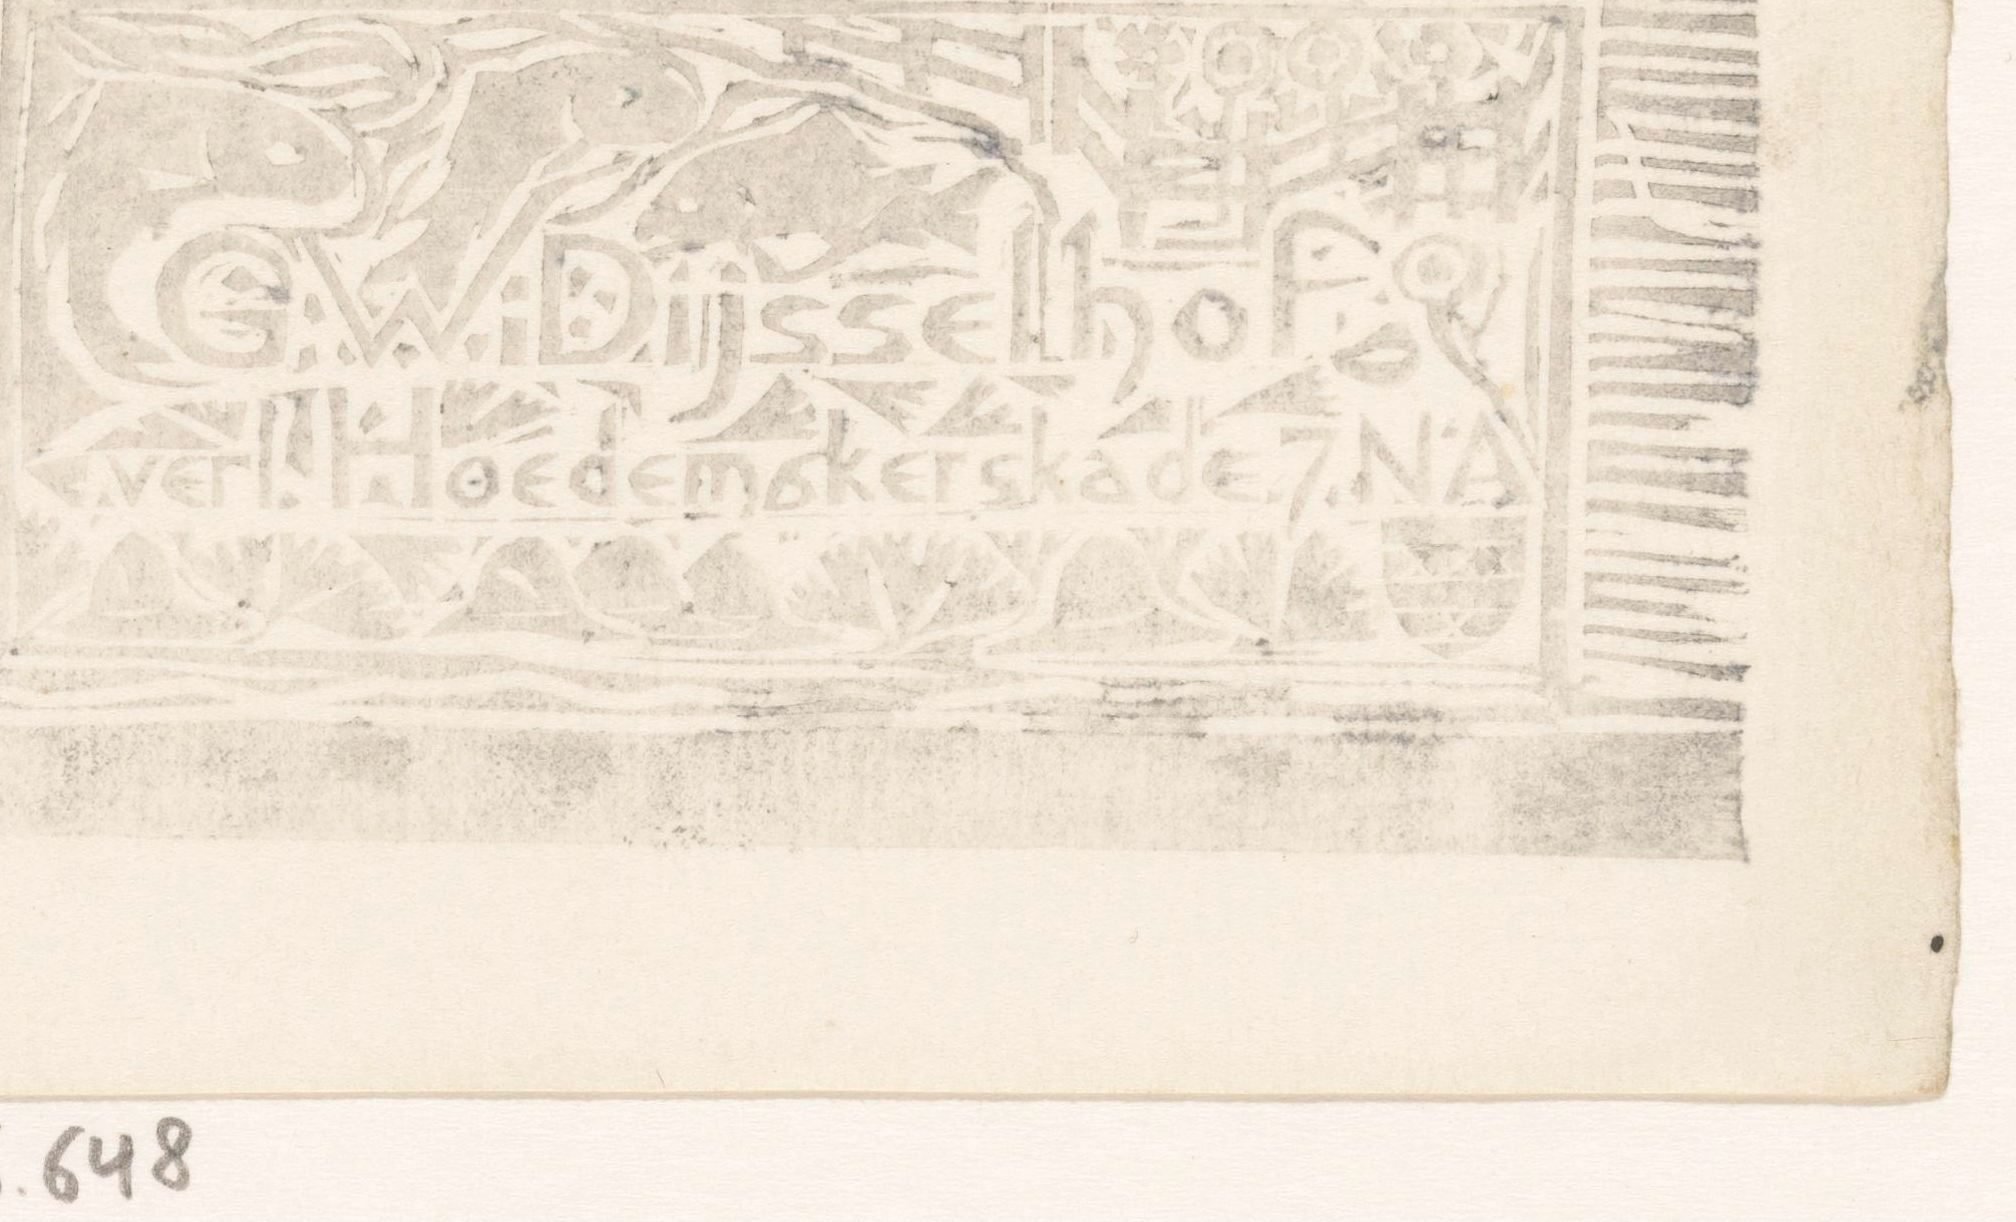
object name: visiting card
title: Visitekaartje van Gerrit Willem Dijsselhof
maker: gerrit willem dijsselhof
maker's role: designer, draughtsman, print maker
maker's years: 1866-1924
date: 1892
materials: paper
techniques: woodcut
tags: print maker, draughtsman, designer, gerrit willem dijsselhof, visiting-card, calling-card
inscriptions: collector's mark: Lugt 2228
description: Een visitekaartje met bloemen bij een tuinhek, drie vissen, een rij hoeden, het wapen van Nieuwer-Amstel en het adres van Gerrit Willem Dijsselhof: Verlengde Hoedemakerskade 7 te Nieuwer-Amstel, de huidige Sint Willibrordusstraat in Amsterdam.